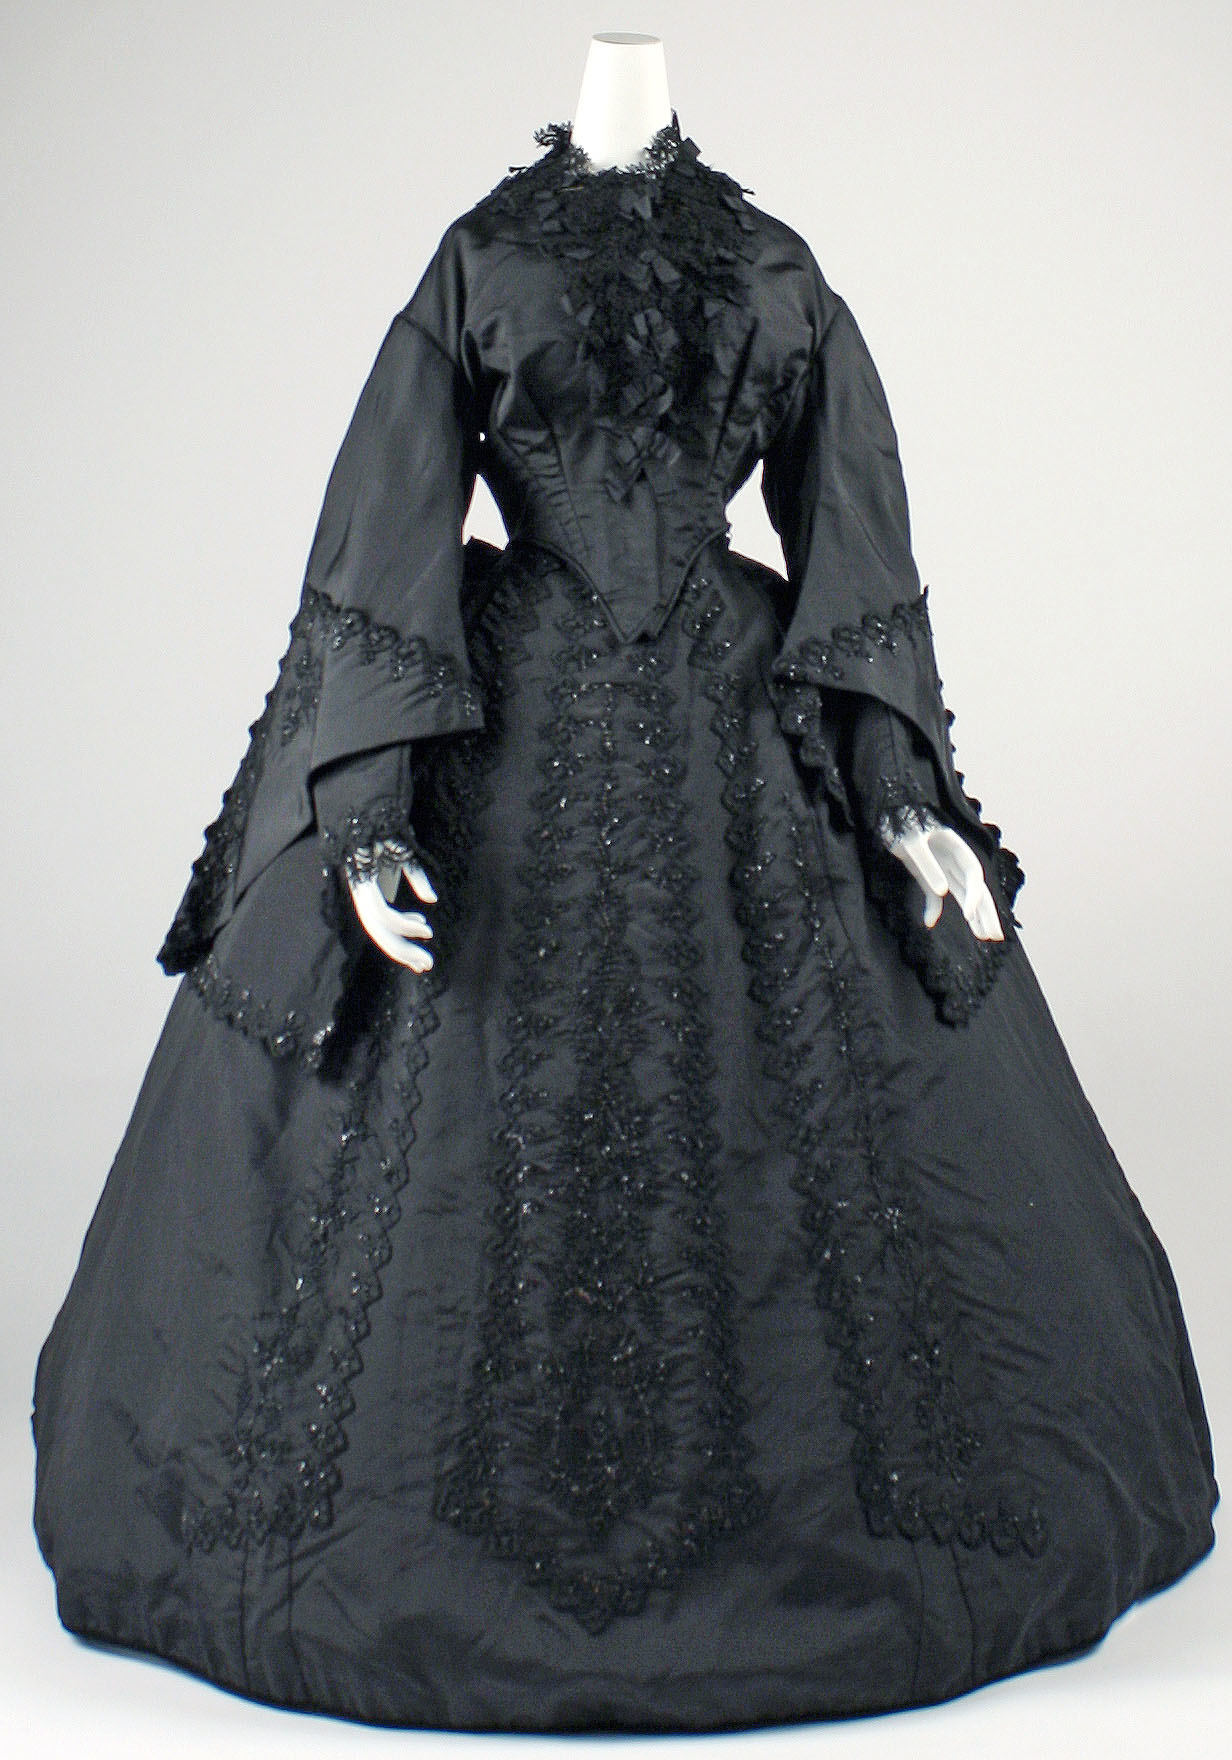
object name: dress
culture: american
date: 1867-1869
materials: silk